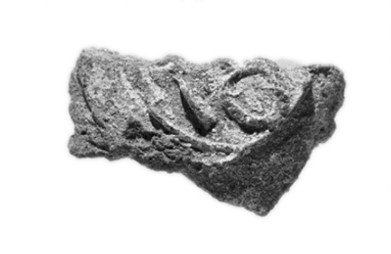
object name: sealing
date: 1981-1640 BCE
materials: mud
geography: egypt